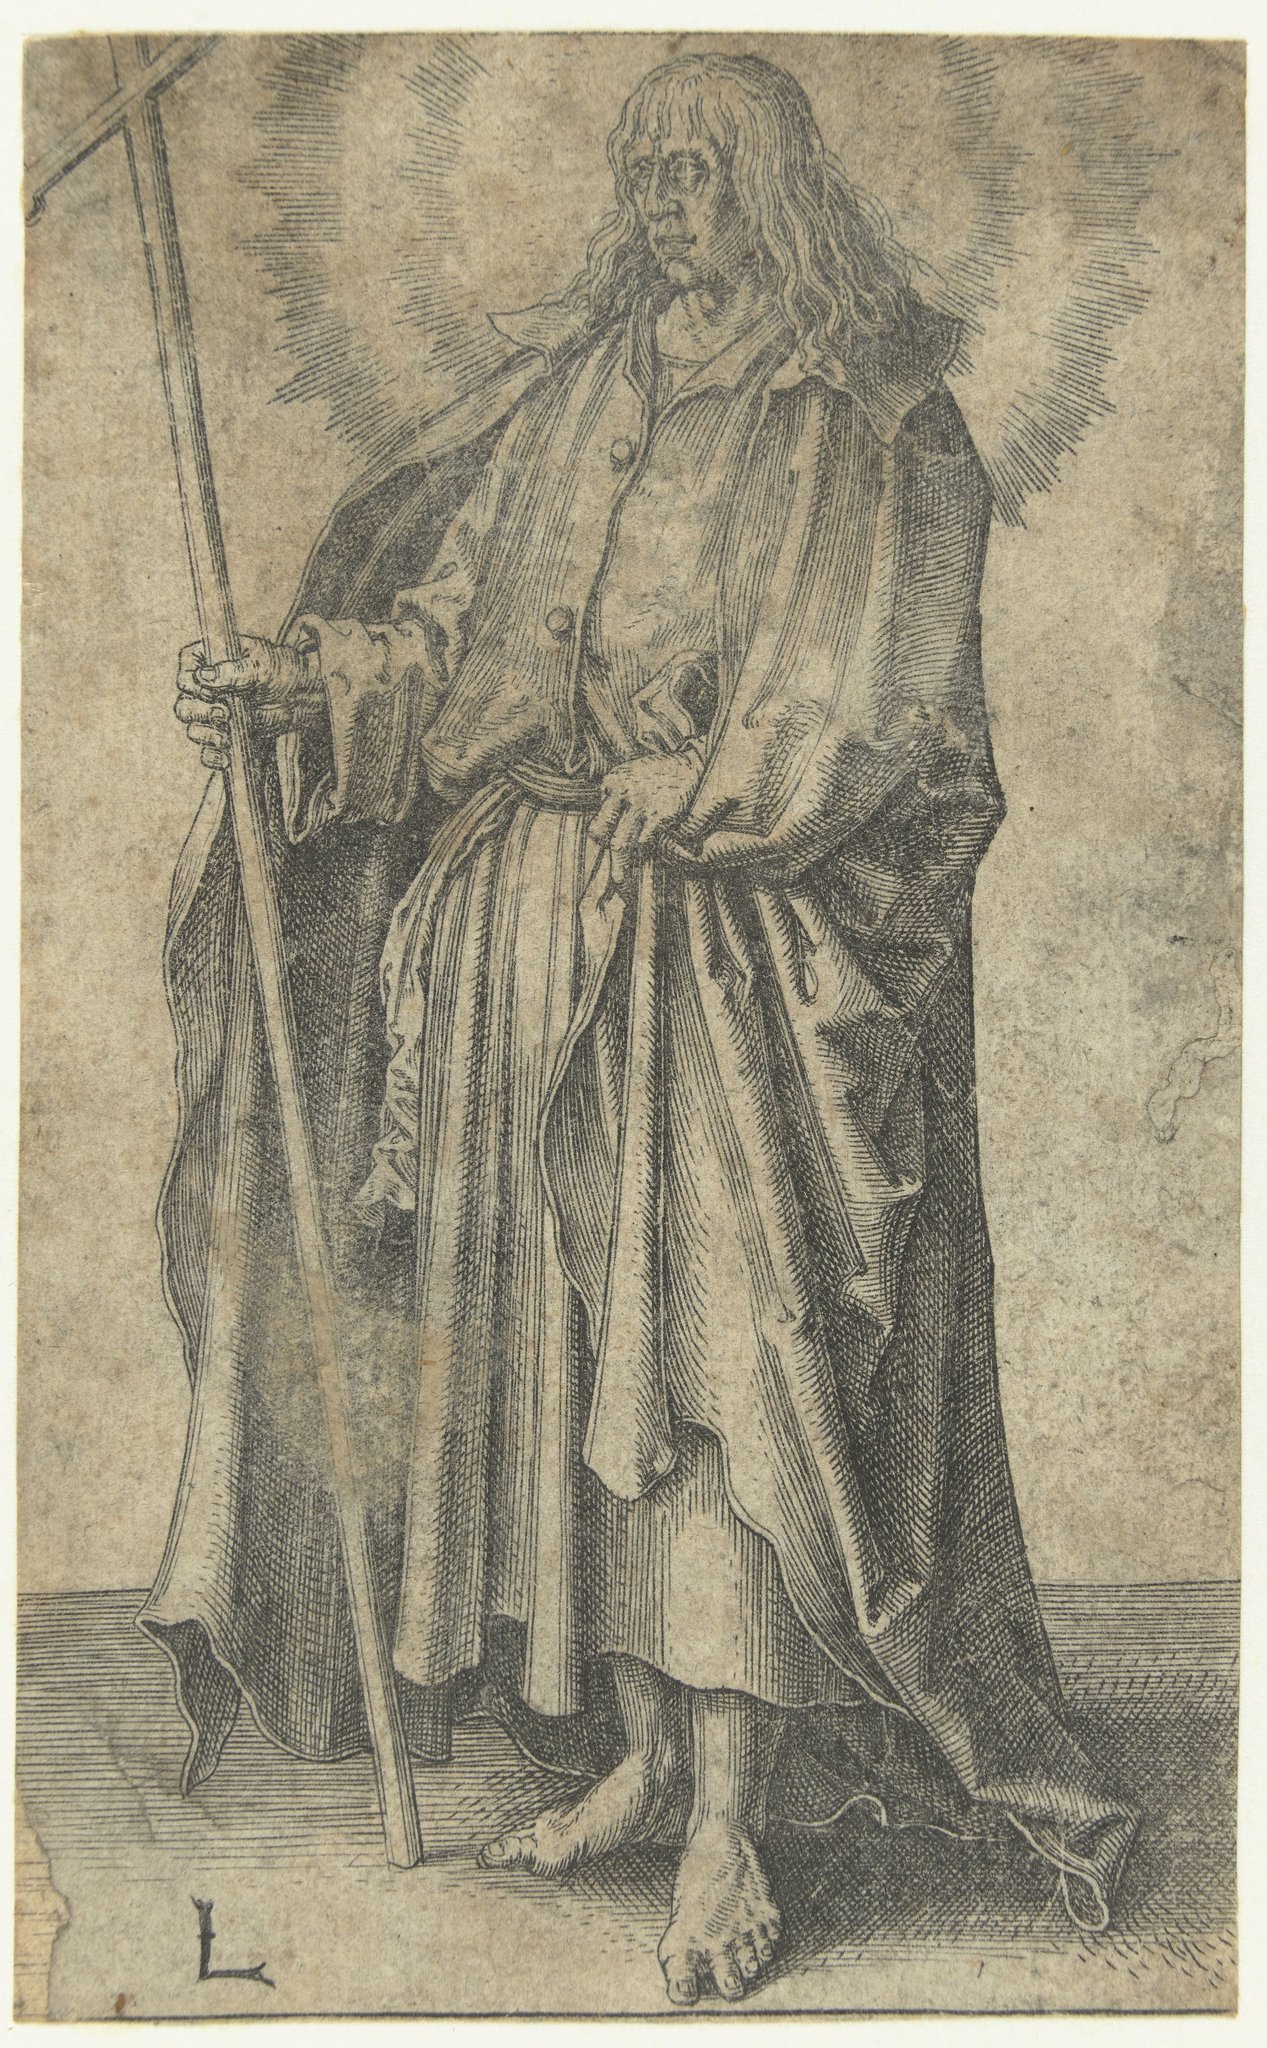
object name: print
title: De apostel Philippus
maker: lucas van leyden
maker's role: draughtsman, painter, print maker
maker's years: 1494-1533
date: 1508-1512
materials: paper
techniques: engraving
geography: low countries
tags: the apostle philip; possible attributes: book, cross, dish with snake, lance, scroll, stone, sword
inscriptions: collector's mark: Lugt 11